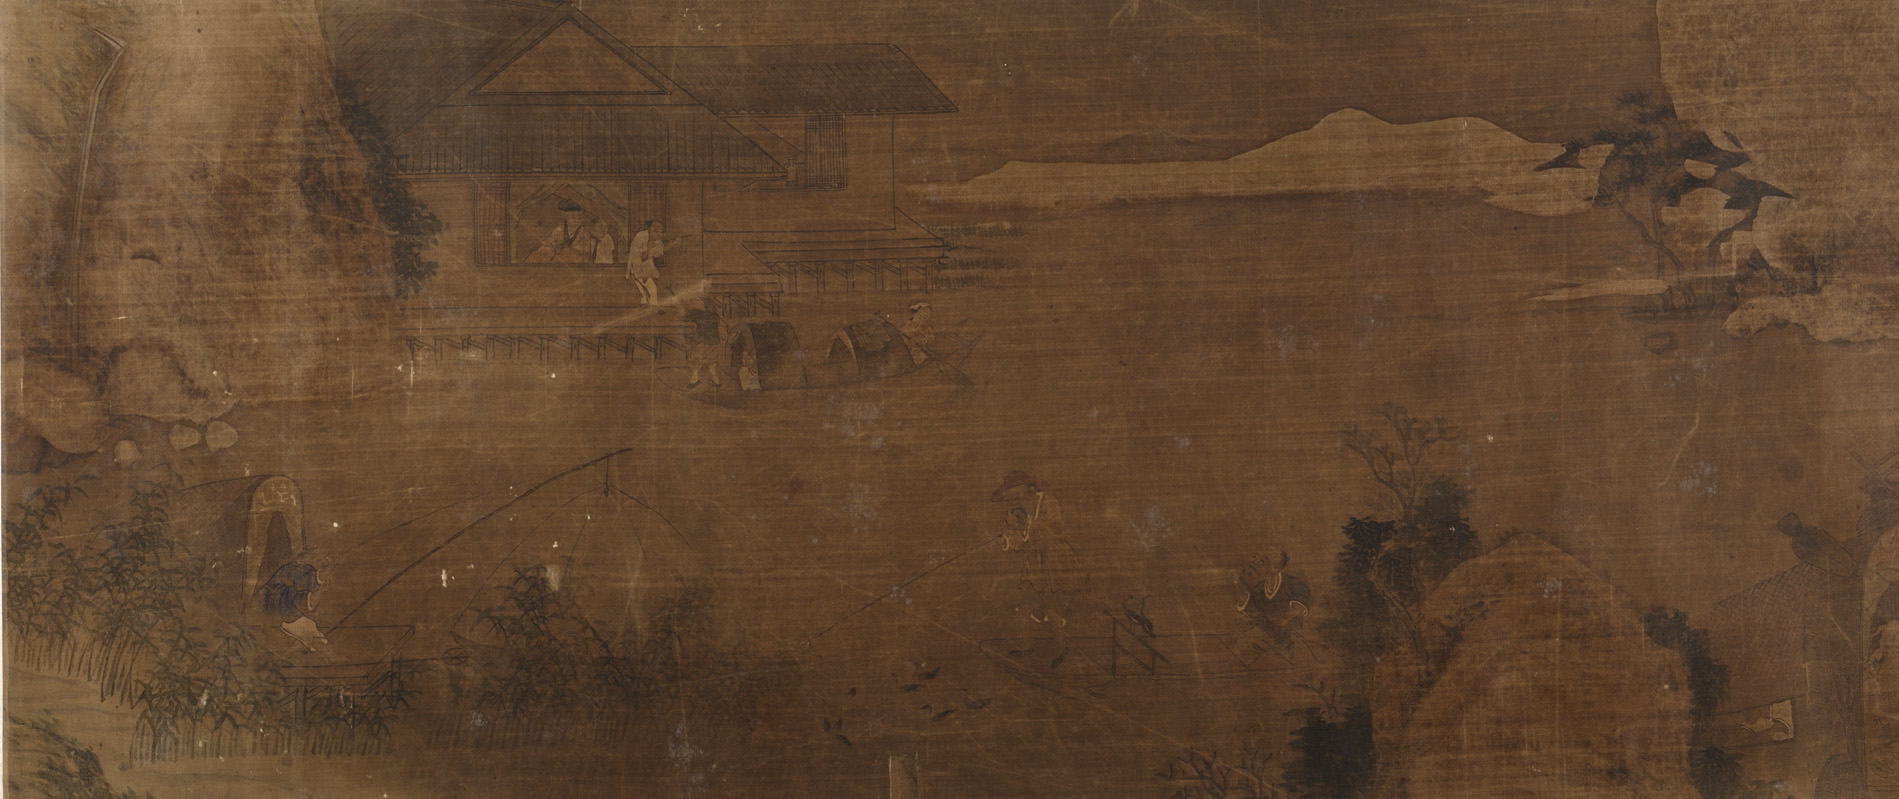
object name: handscroll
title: Fishing Scene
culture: chinese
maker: unidentified artist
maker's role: artist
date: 1368-1911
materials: ink, silk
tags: men,fishing